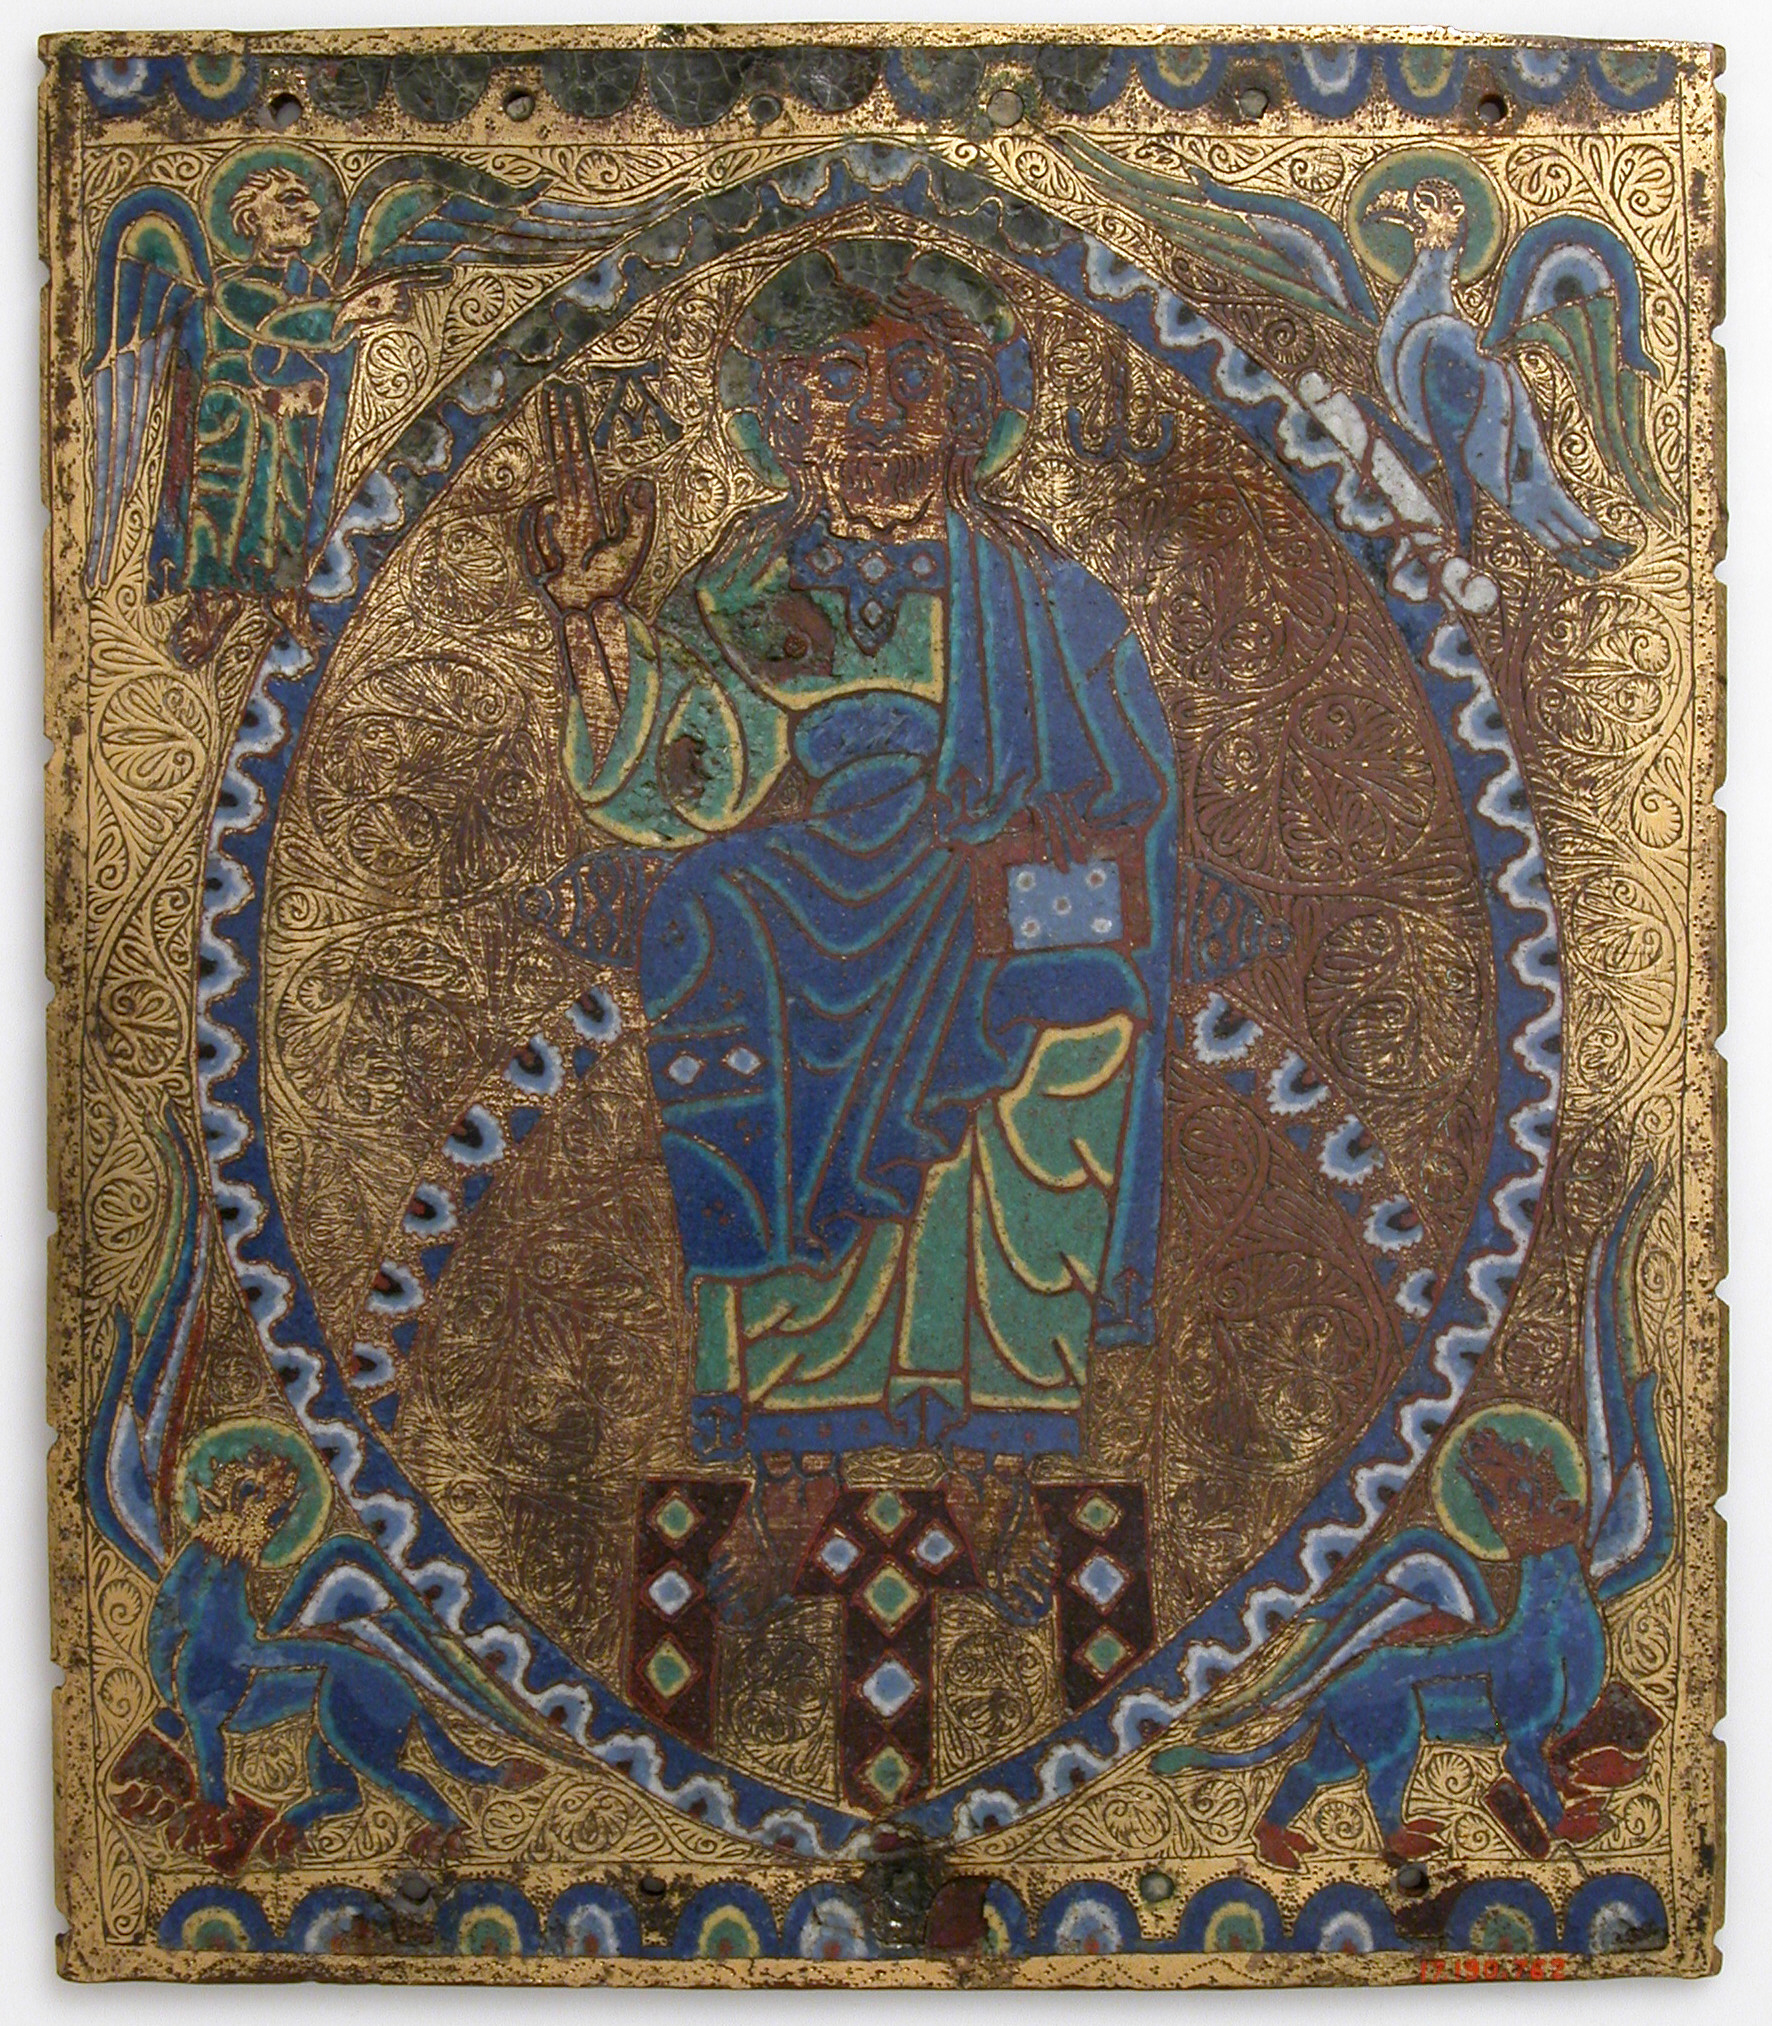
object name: plaque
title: Plaque of Christ in Majesty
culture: french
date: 1101-1300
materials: copper, enamel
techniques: enamel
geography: france